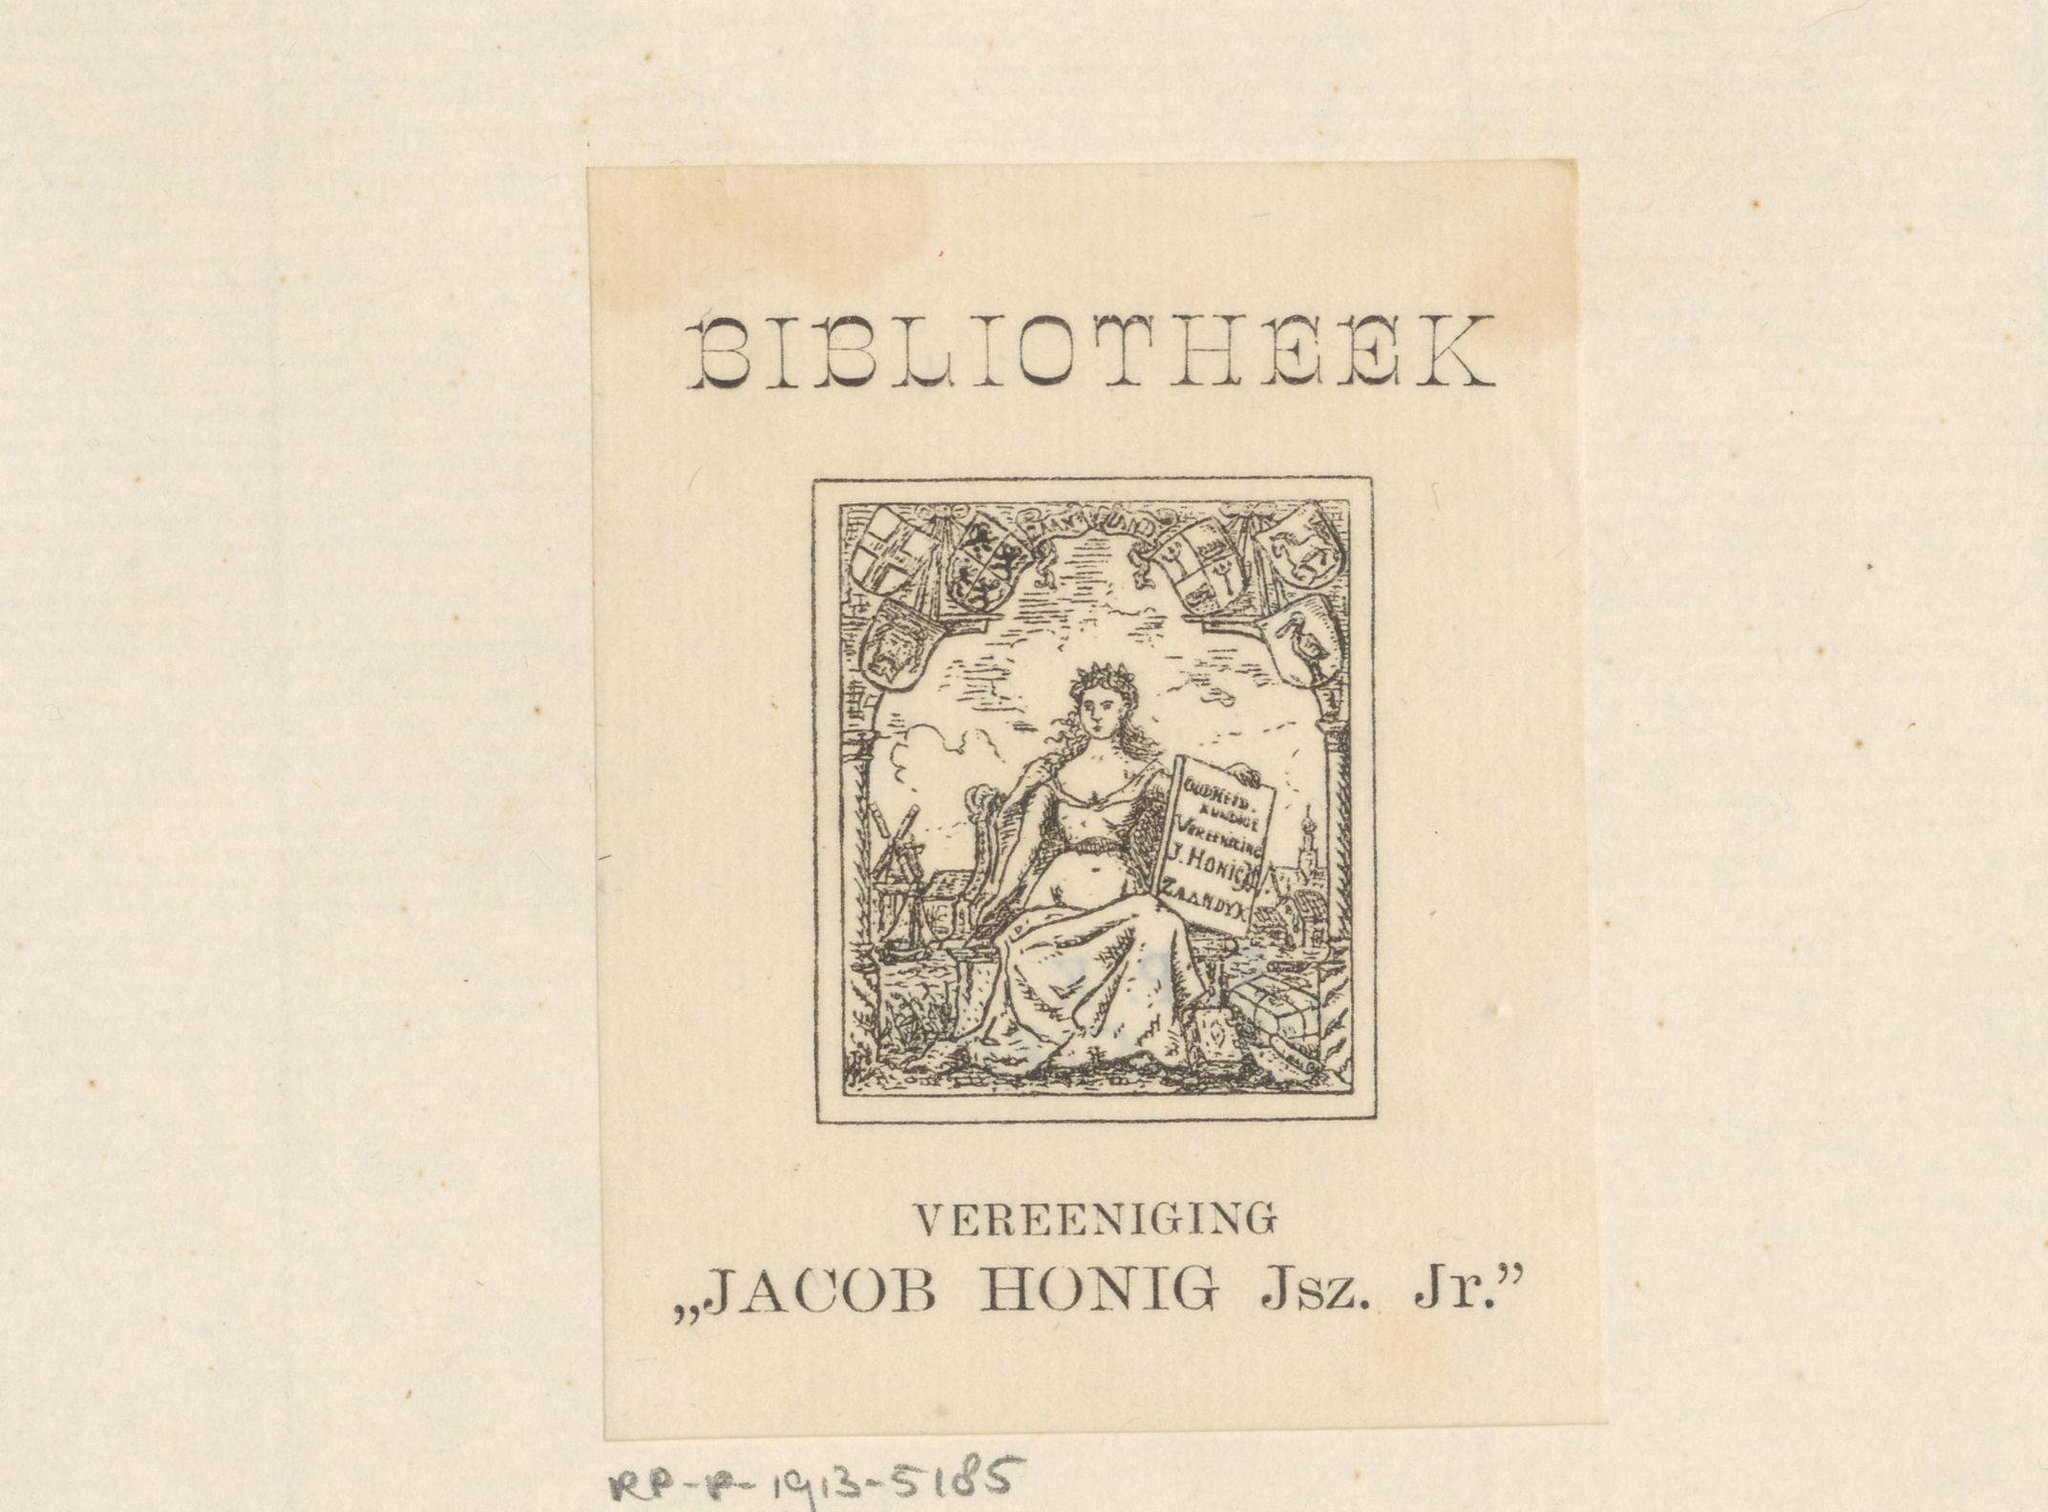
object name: bookplate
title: Ex libris van de Vereeniging Jacob Honig Jsz. jr.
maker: Anonymous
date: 1890-1913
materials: paper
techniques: printing block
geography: netherlands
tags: 'historia'; 'historia' (ripa), windmill, armorial bearing, heraldry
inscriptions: collector's mark: Lugt 2760, collector's mark: Lugt 2233